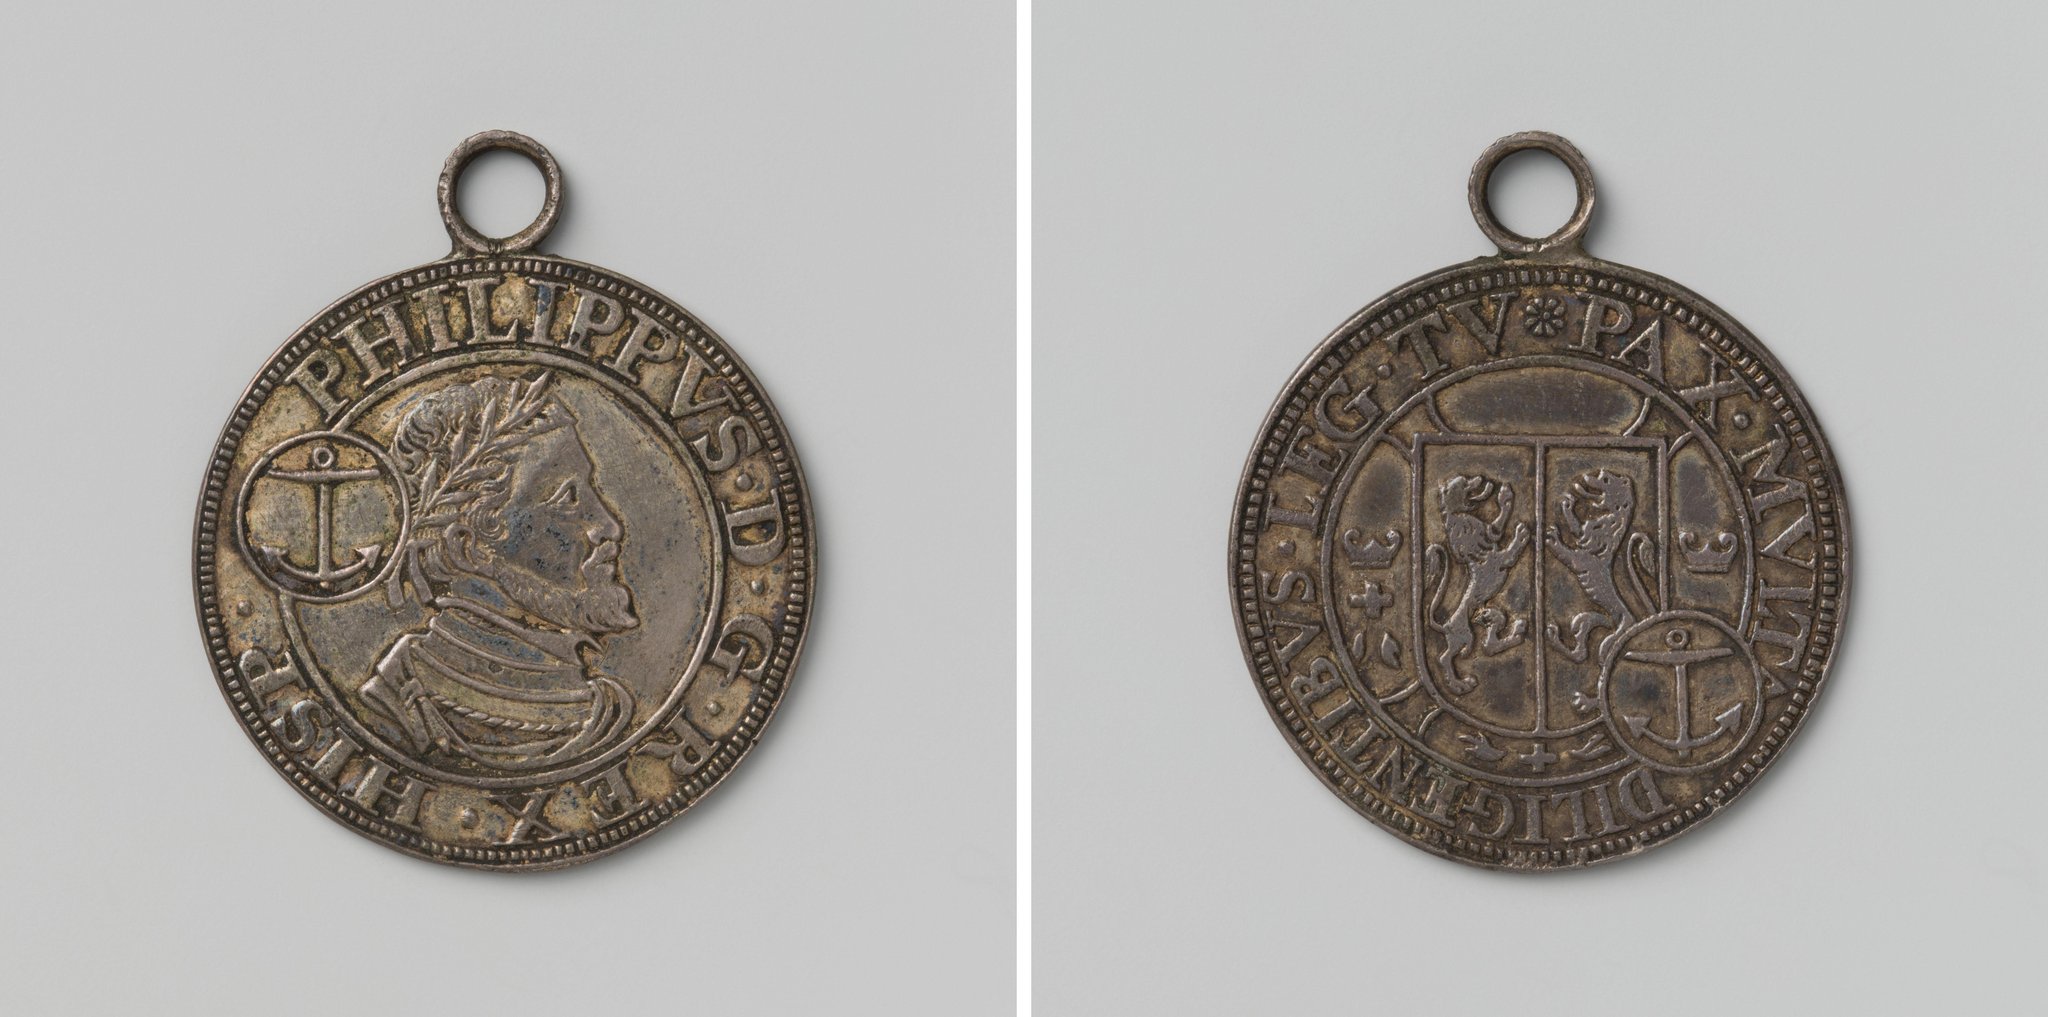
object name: coin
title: Daalder, imitatie-noodmunt van Steenwijk, met het uiterlijk van een halve philipsdaalder, imitatie van een munt met instempeling gebruikt tijdens het beleg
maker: Anonymous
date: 1883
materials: silver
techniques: striking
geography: steenwijk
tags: steenwijk, tachtigjarige oorlog, beleg en ontzet van steenwijk